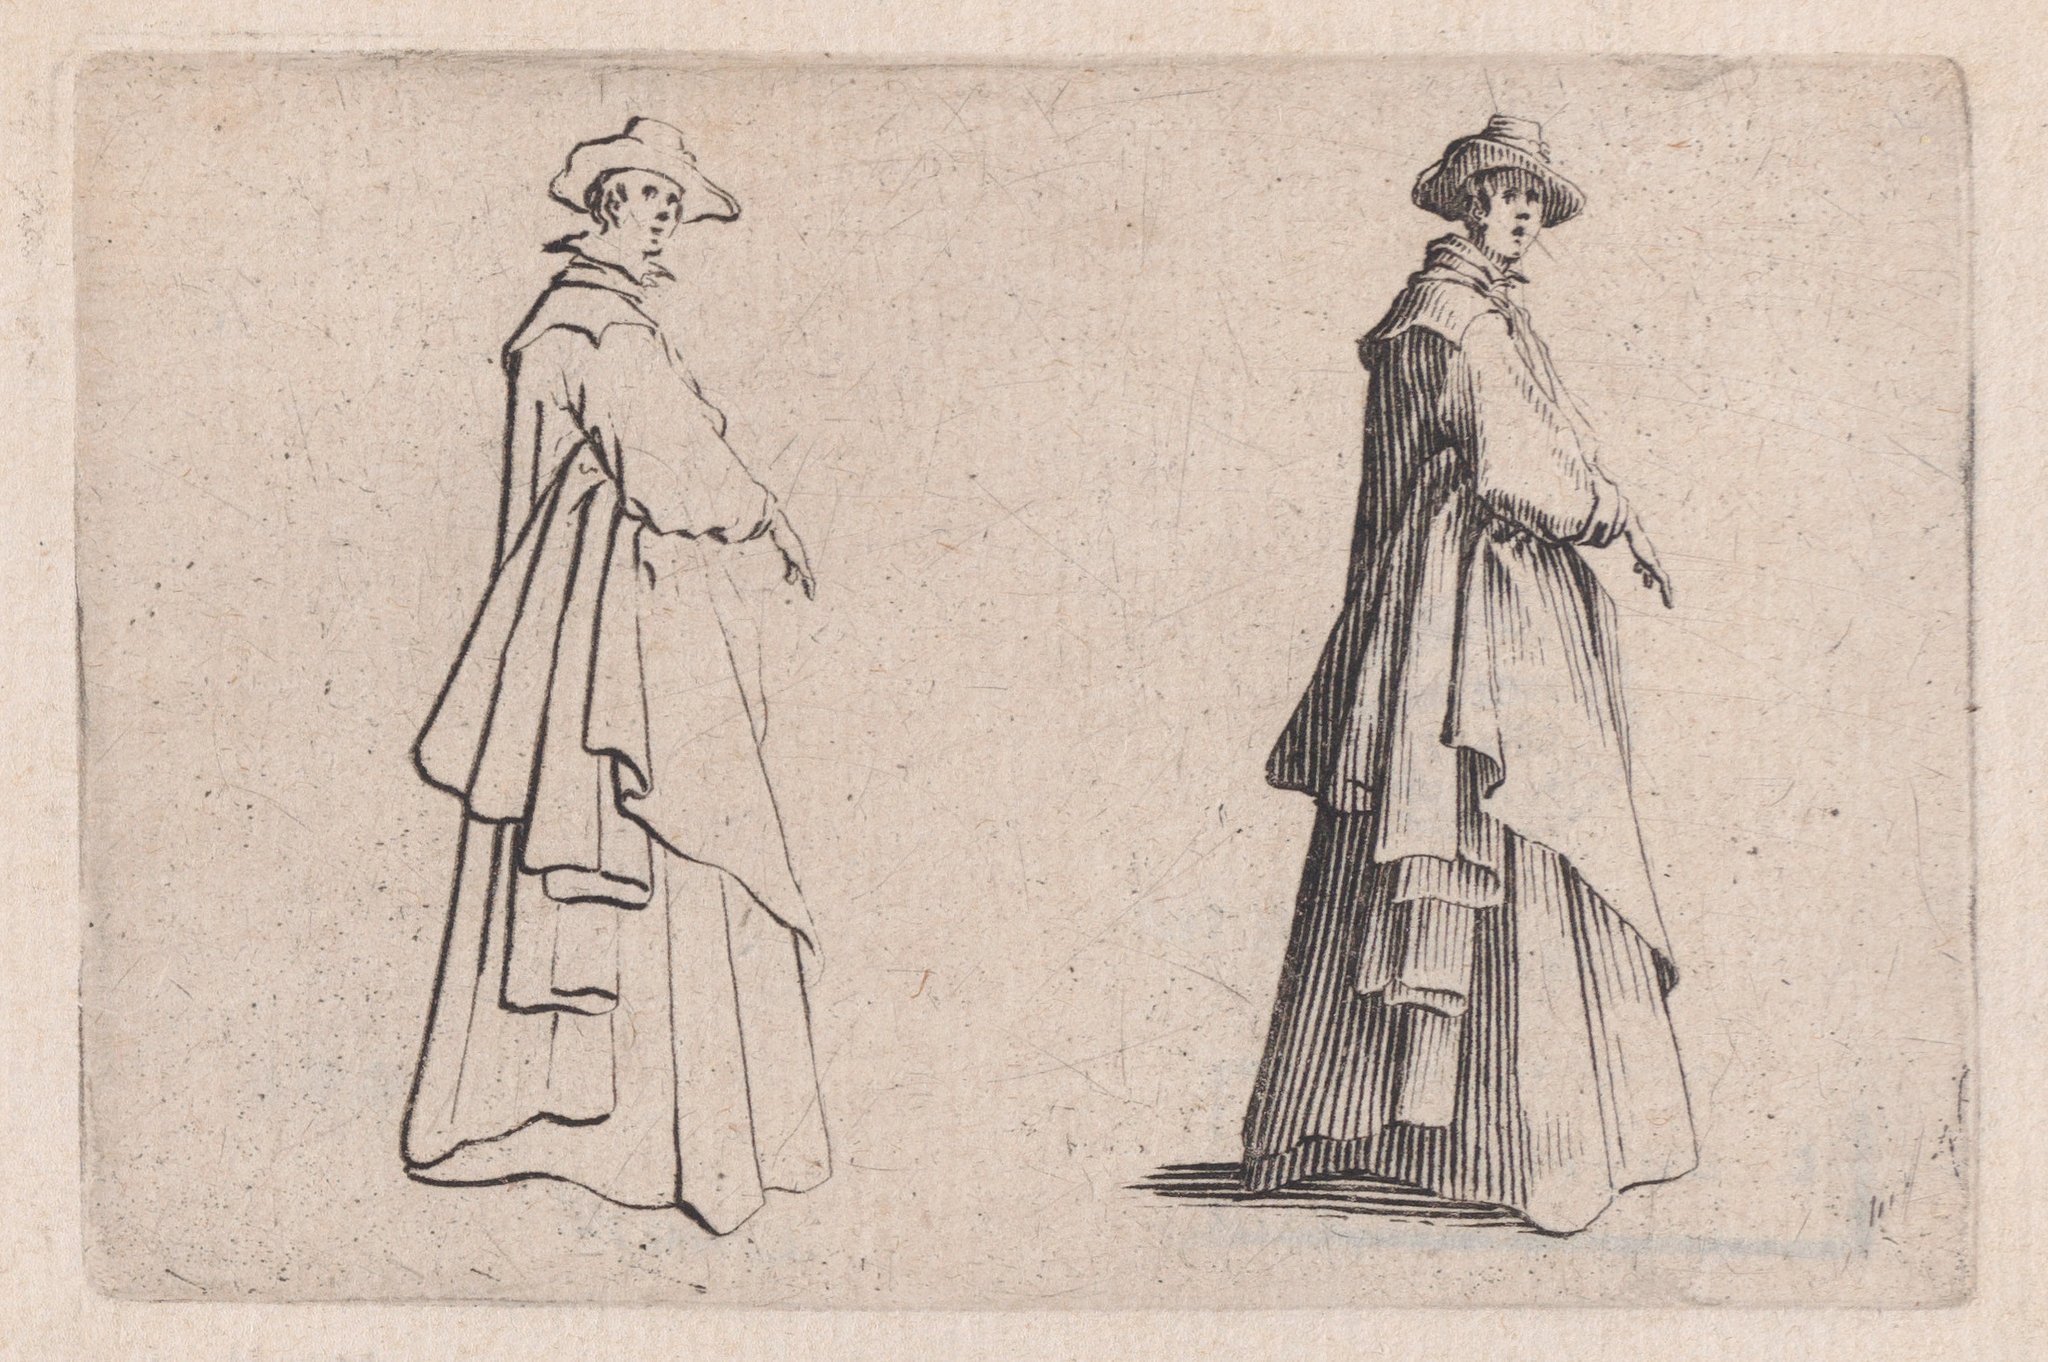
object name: print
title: La Dame au Vêtement Ample (The Woman with Ample Clothing), from "Les Caprices" Series B, The Nancy Set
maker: jacques callot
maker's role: artist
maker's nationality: french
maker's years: 1592-1635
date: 1617-1620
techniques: etching